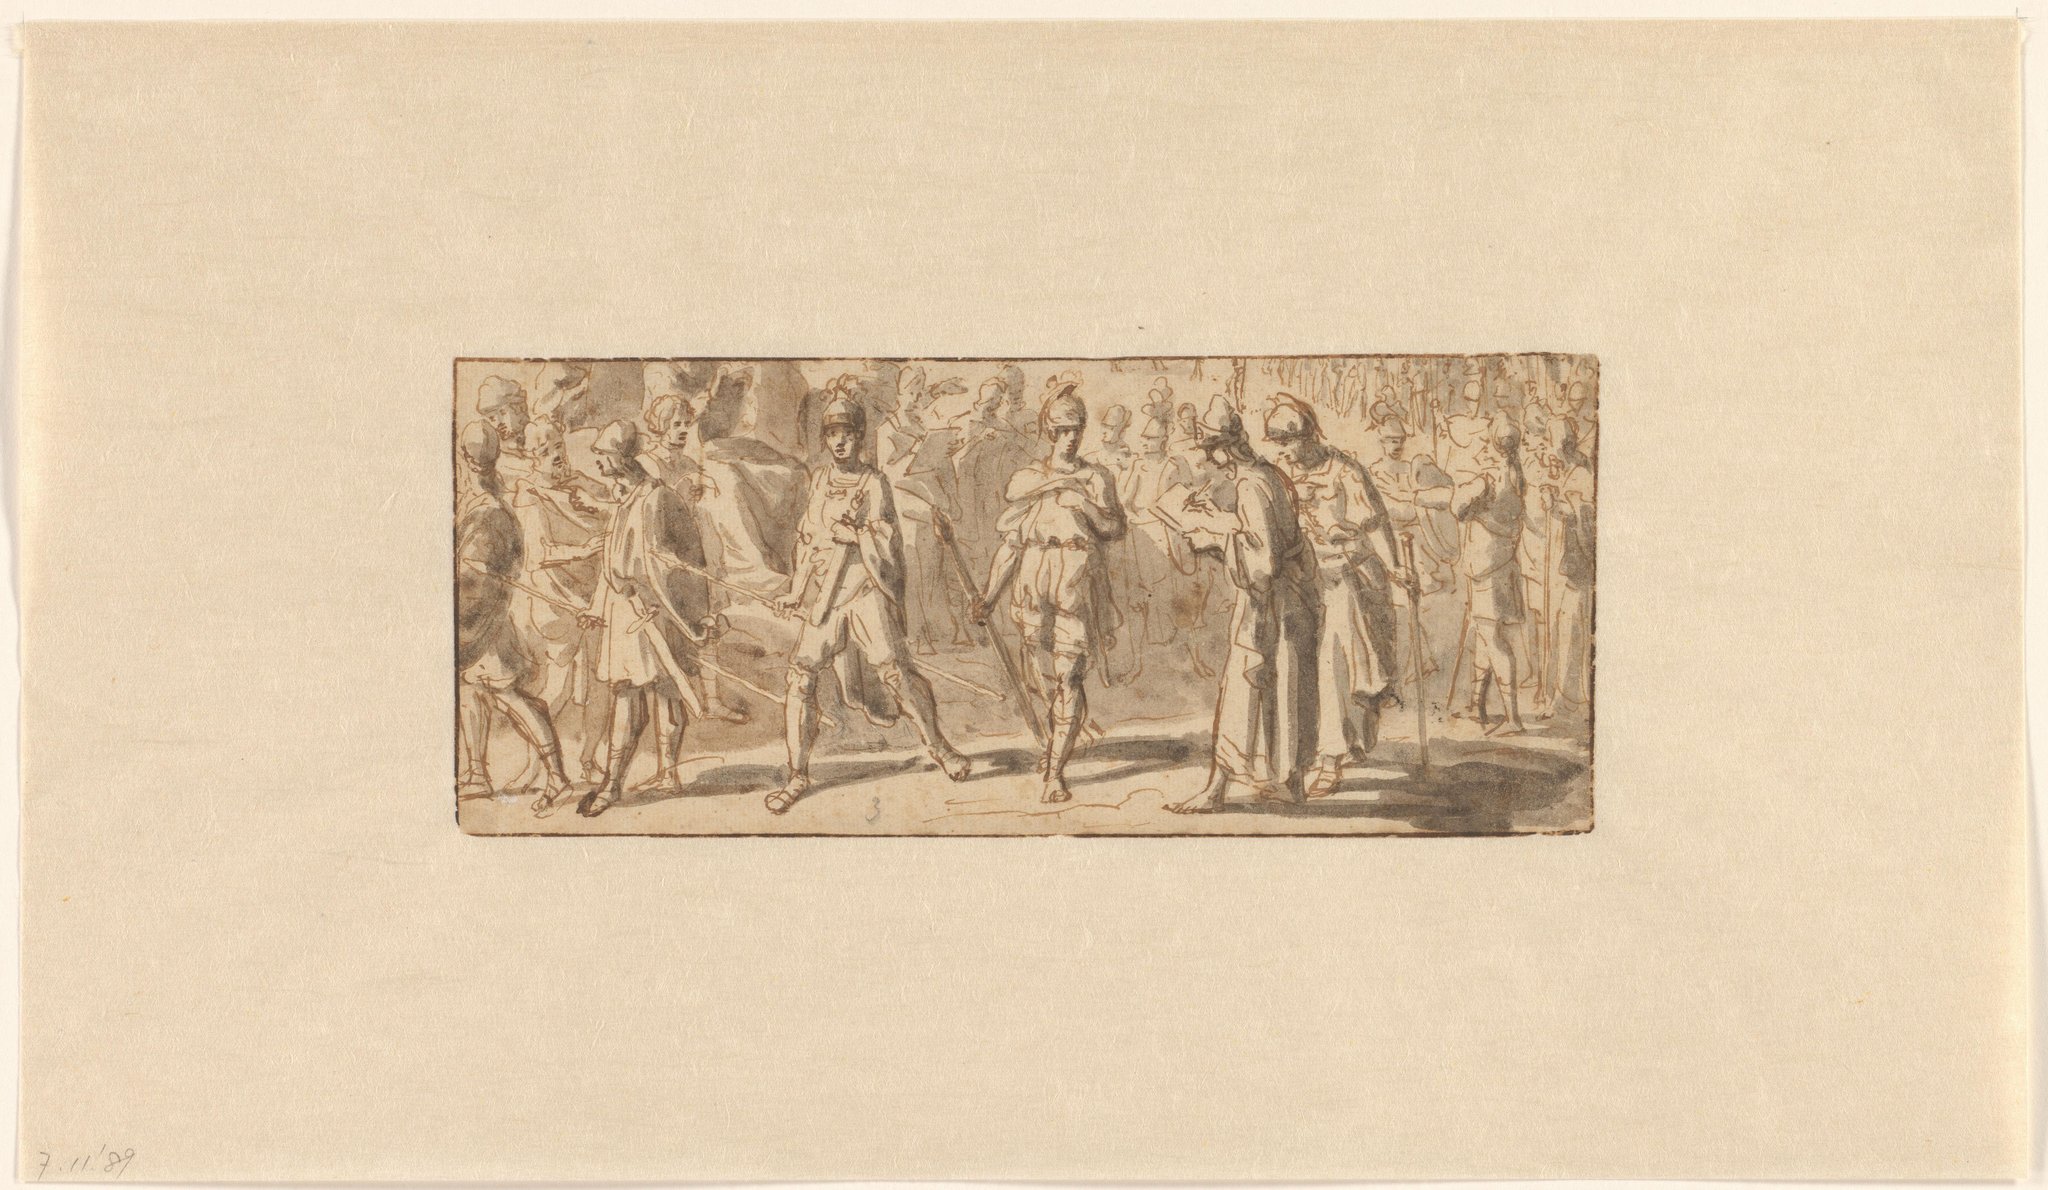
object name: drawing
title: Romeinse soldaten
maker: Anonymous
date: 1600-1699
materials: ink, paper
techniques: brush, pen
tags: male persons from classical history, the soldier; the soldier's life